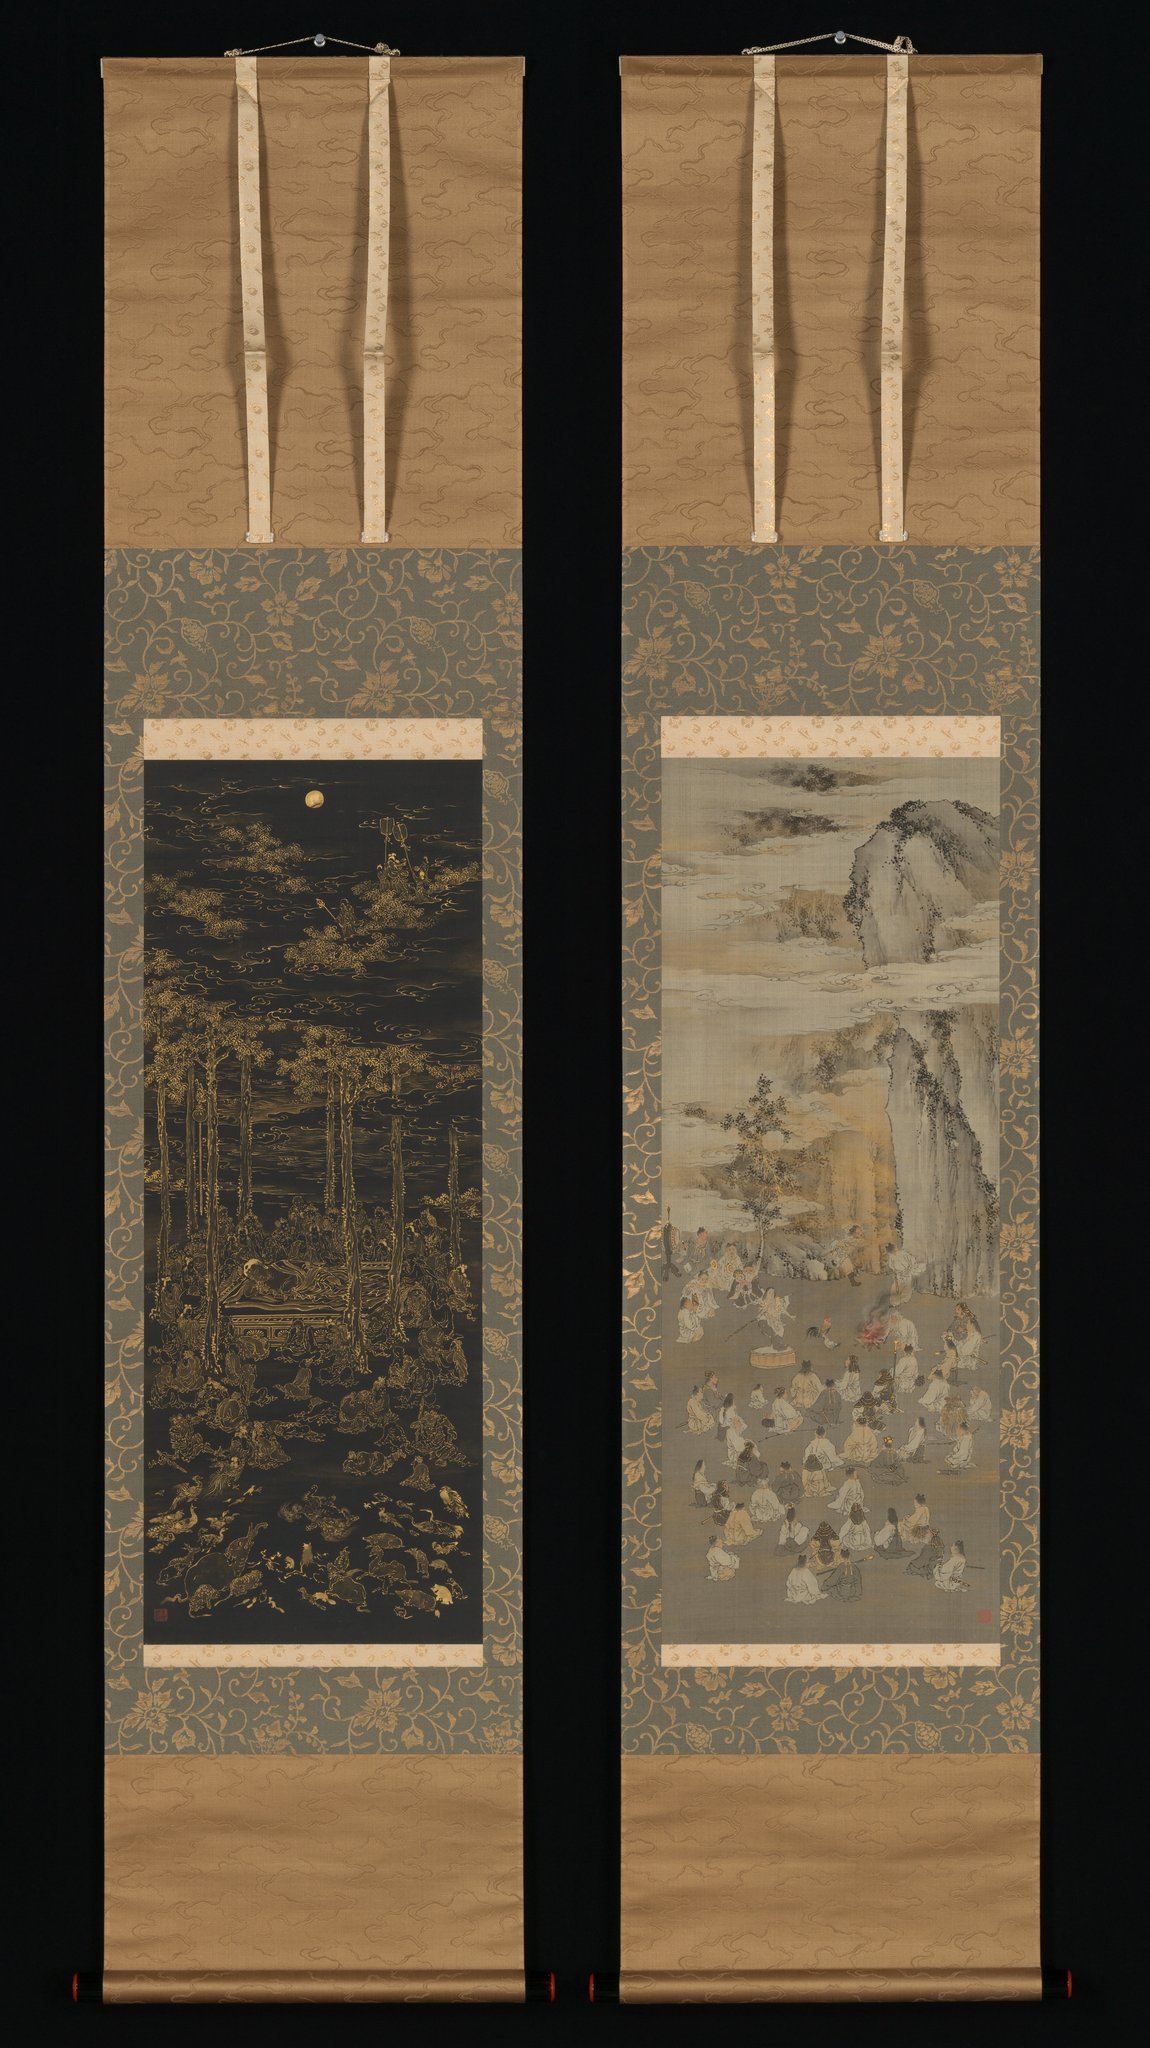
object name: hanging scroll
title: Luring the Sun Goddess Amaterasu Out of a Cave with Music; Death of the Historical Buddha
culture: japanese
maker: kōno bairei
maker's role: artist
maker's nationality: japanese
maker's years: 1844-1895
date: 1867-1900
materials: gold, ink, silk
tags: caves,landscapes